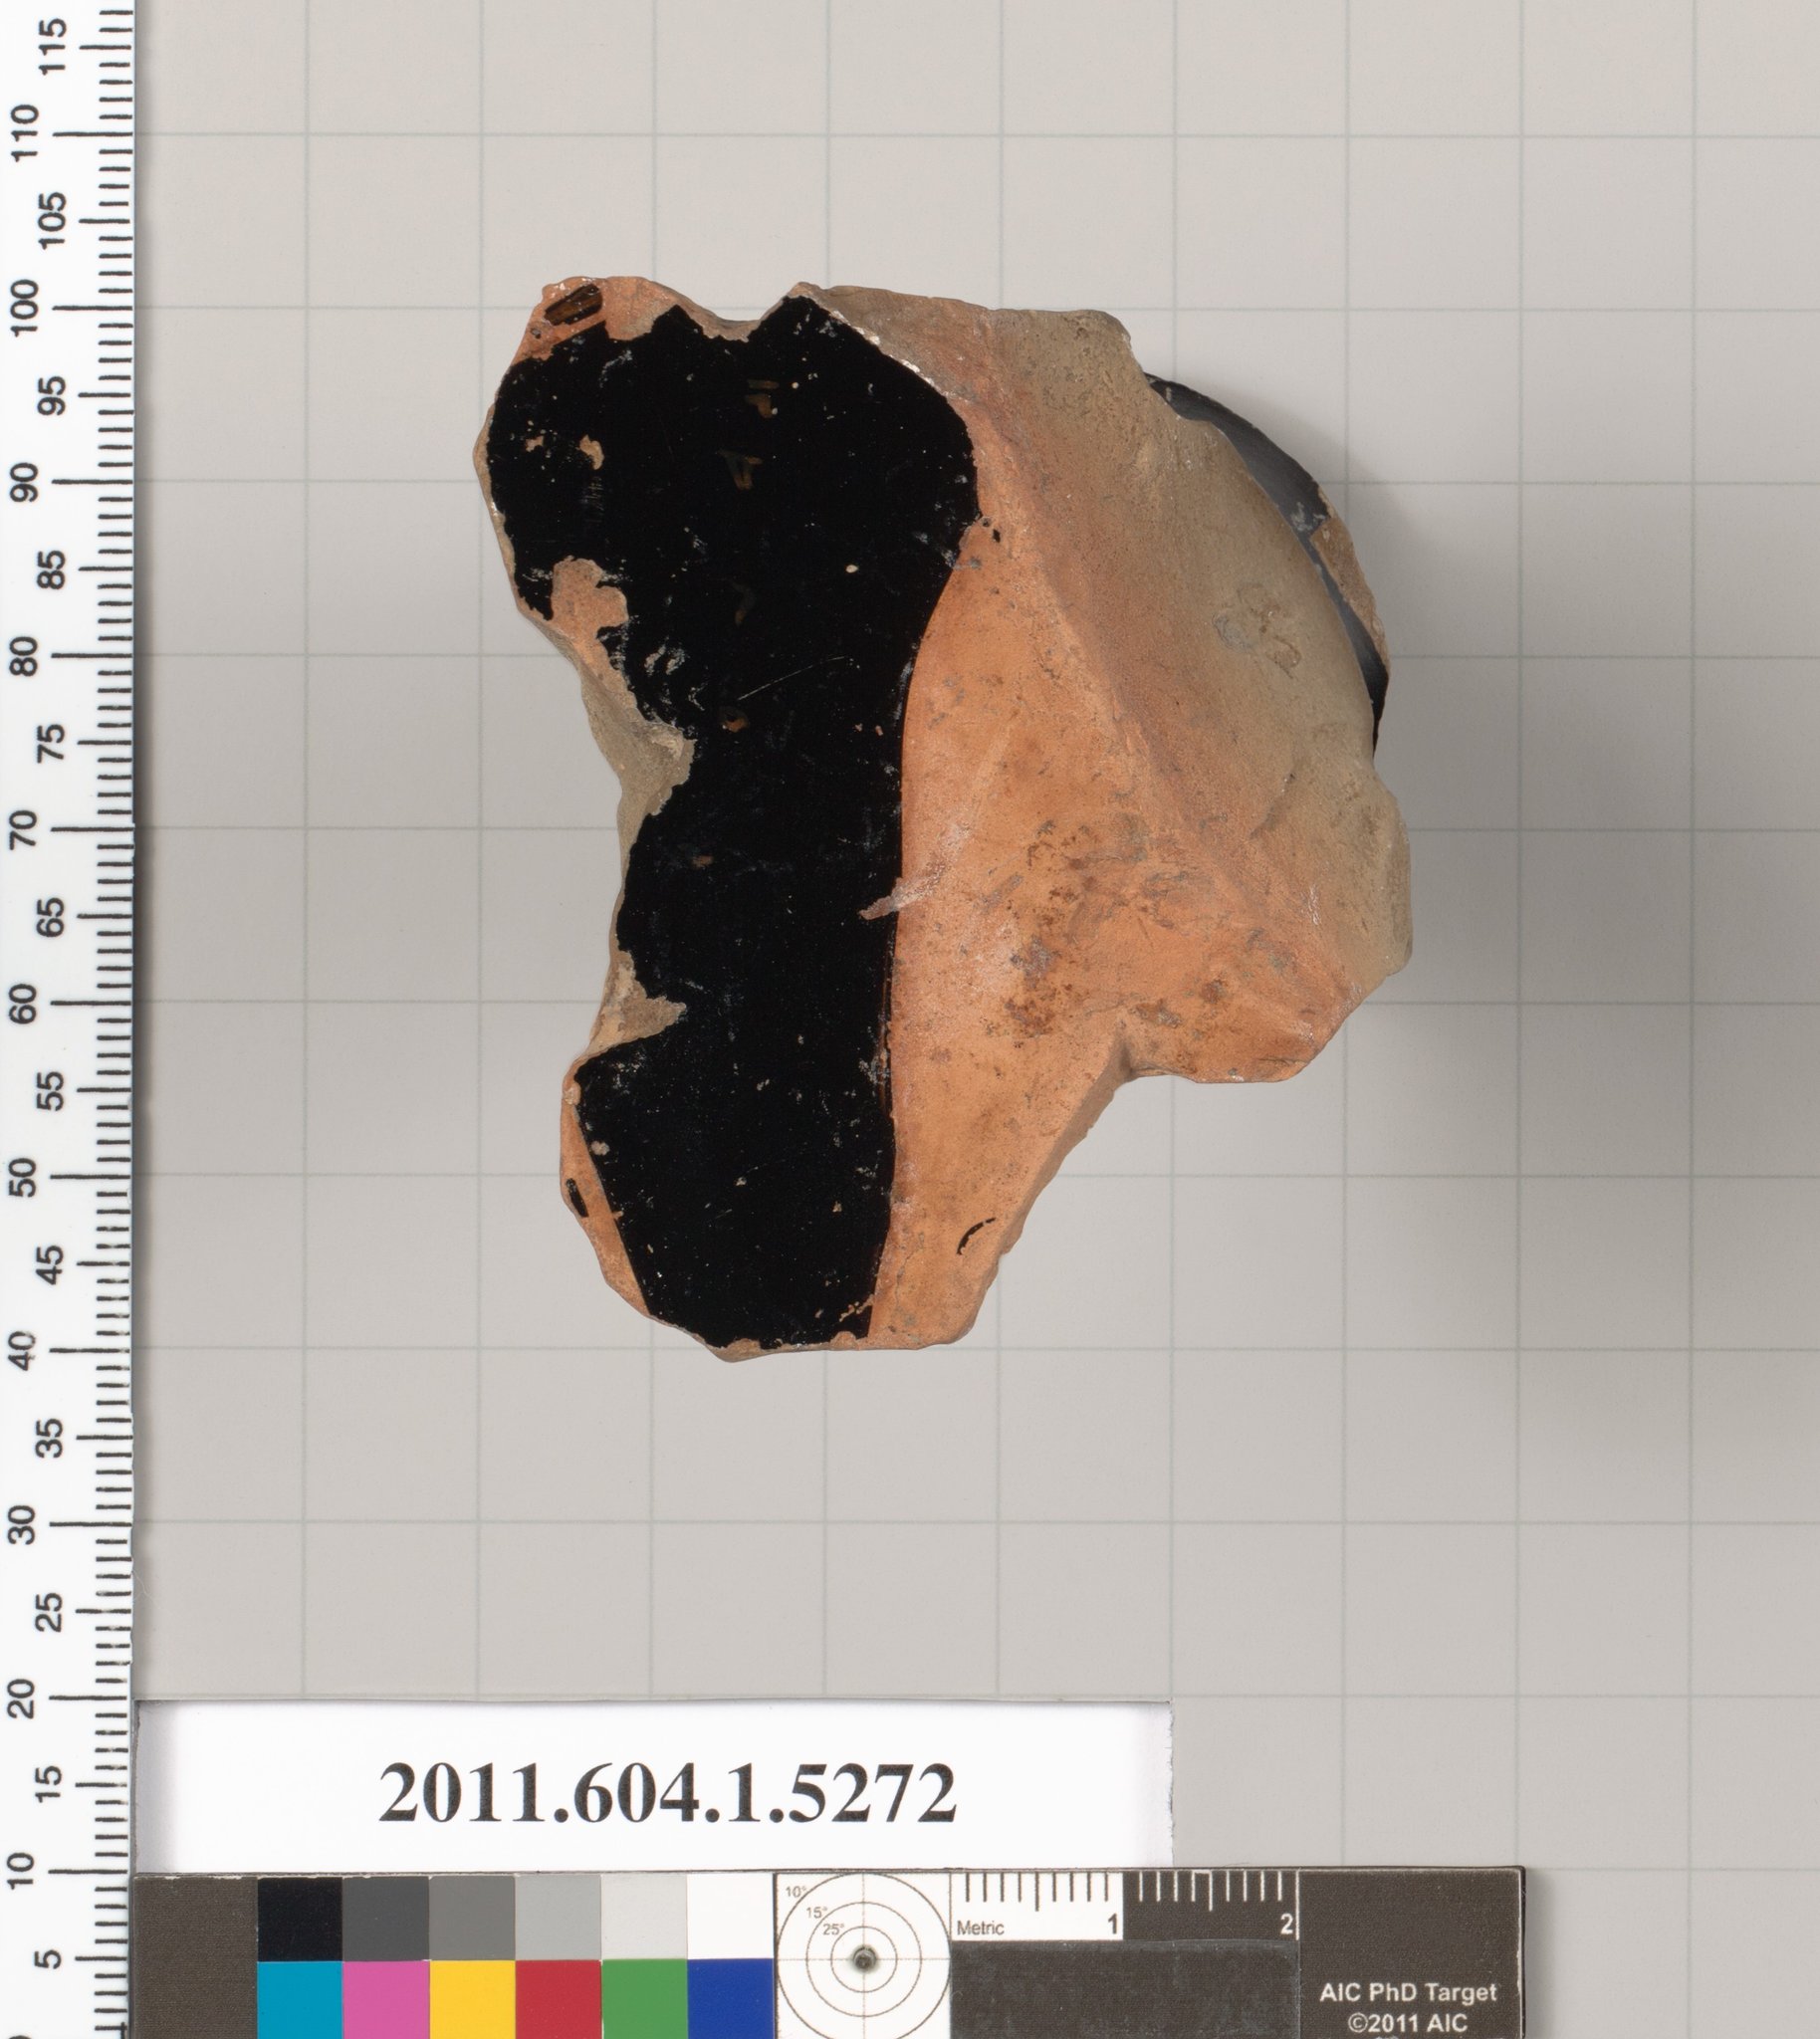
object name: kylix fragment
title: Terracotta fragment of a kylix (drinking cup)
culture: greek, attic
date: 500-480 BCE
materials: terracotta